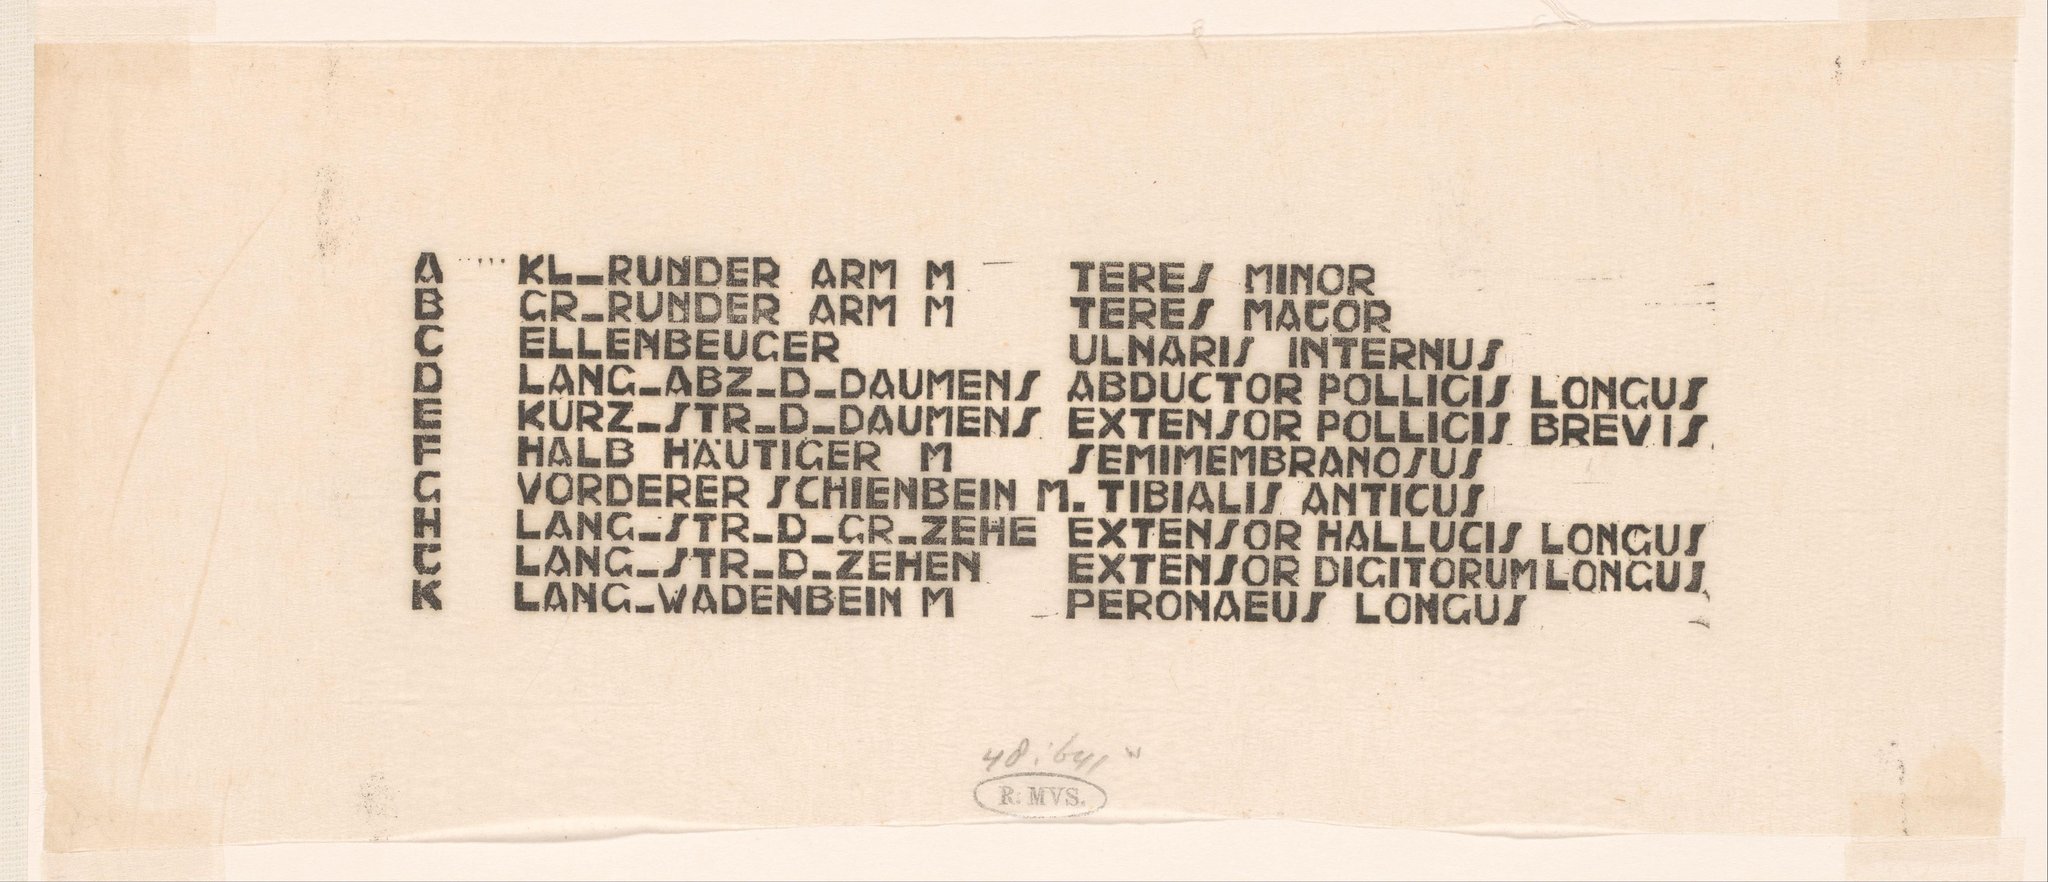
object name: print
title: Lijst van arm- en beenspieren in Duits en Latijn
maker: reijer stolk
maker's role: draughtsman, print maker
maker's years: 1896-1945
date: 1906-1945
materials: paper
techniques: woodcut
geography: netherlands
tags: muscles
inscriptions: collector's mark: Lugt 2228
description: Prent gebruikt voor: Stolk, Reyer. Anatomische studies in houtsneden. Amsterdam: G.W. Breughel, 1946, plaat 5.